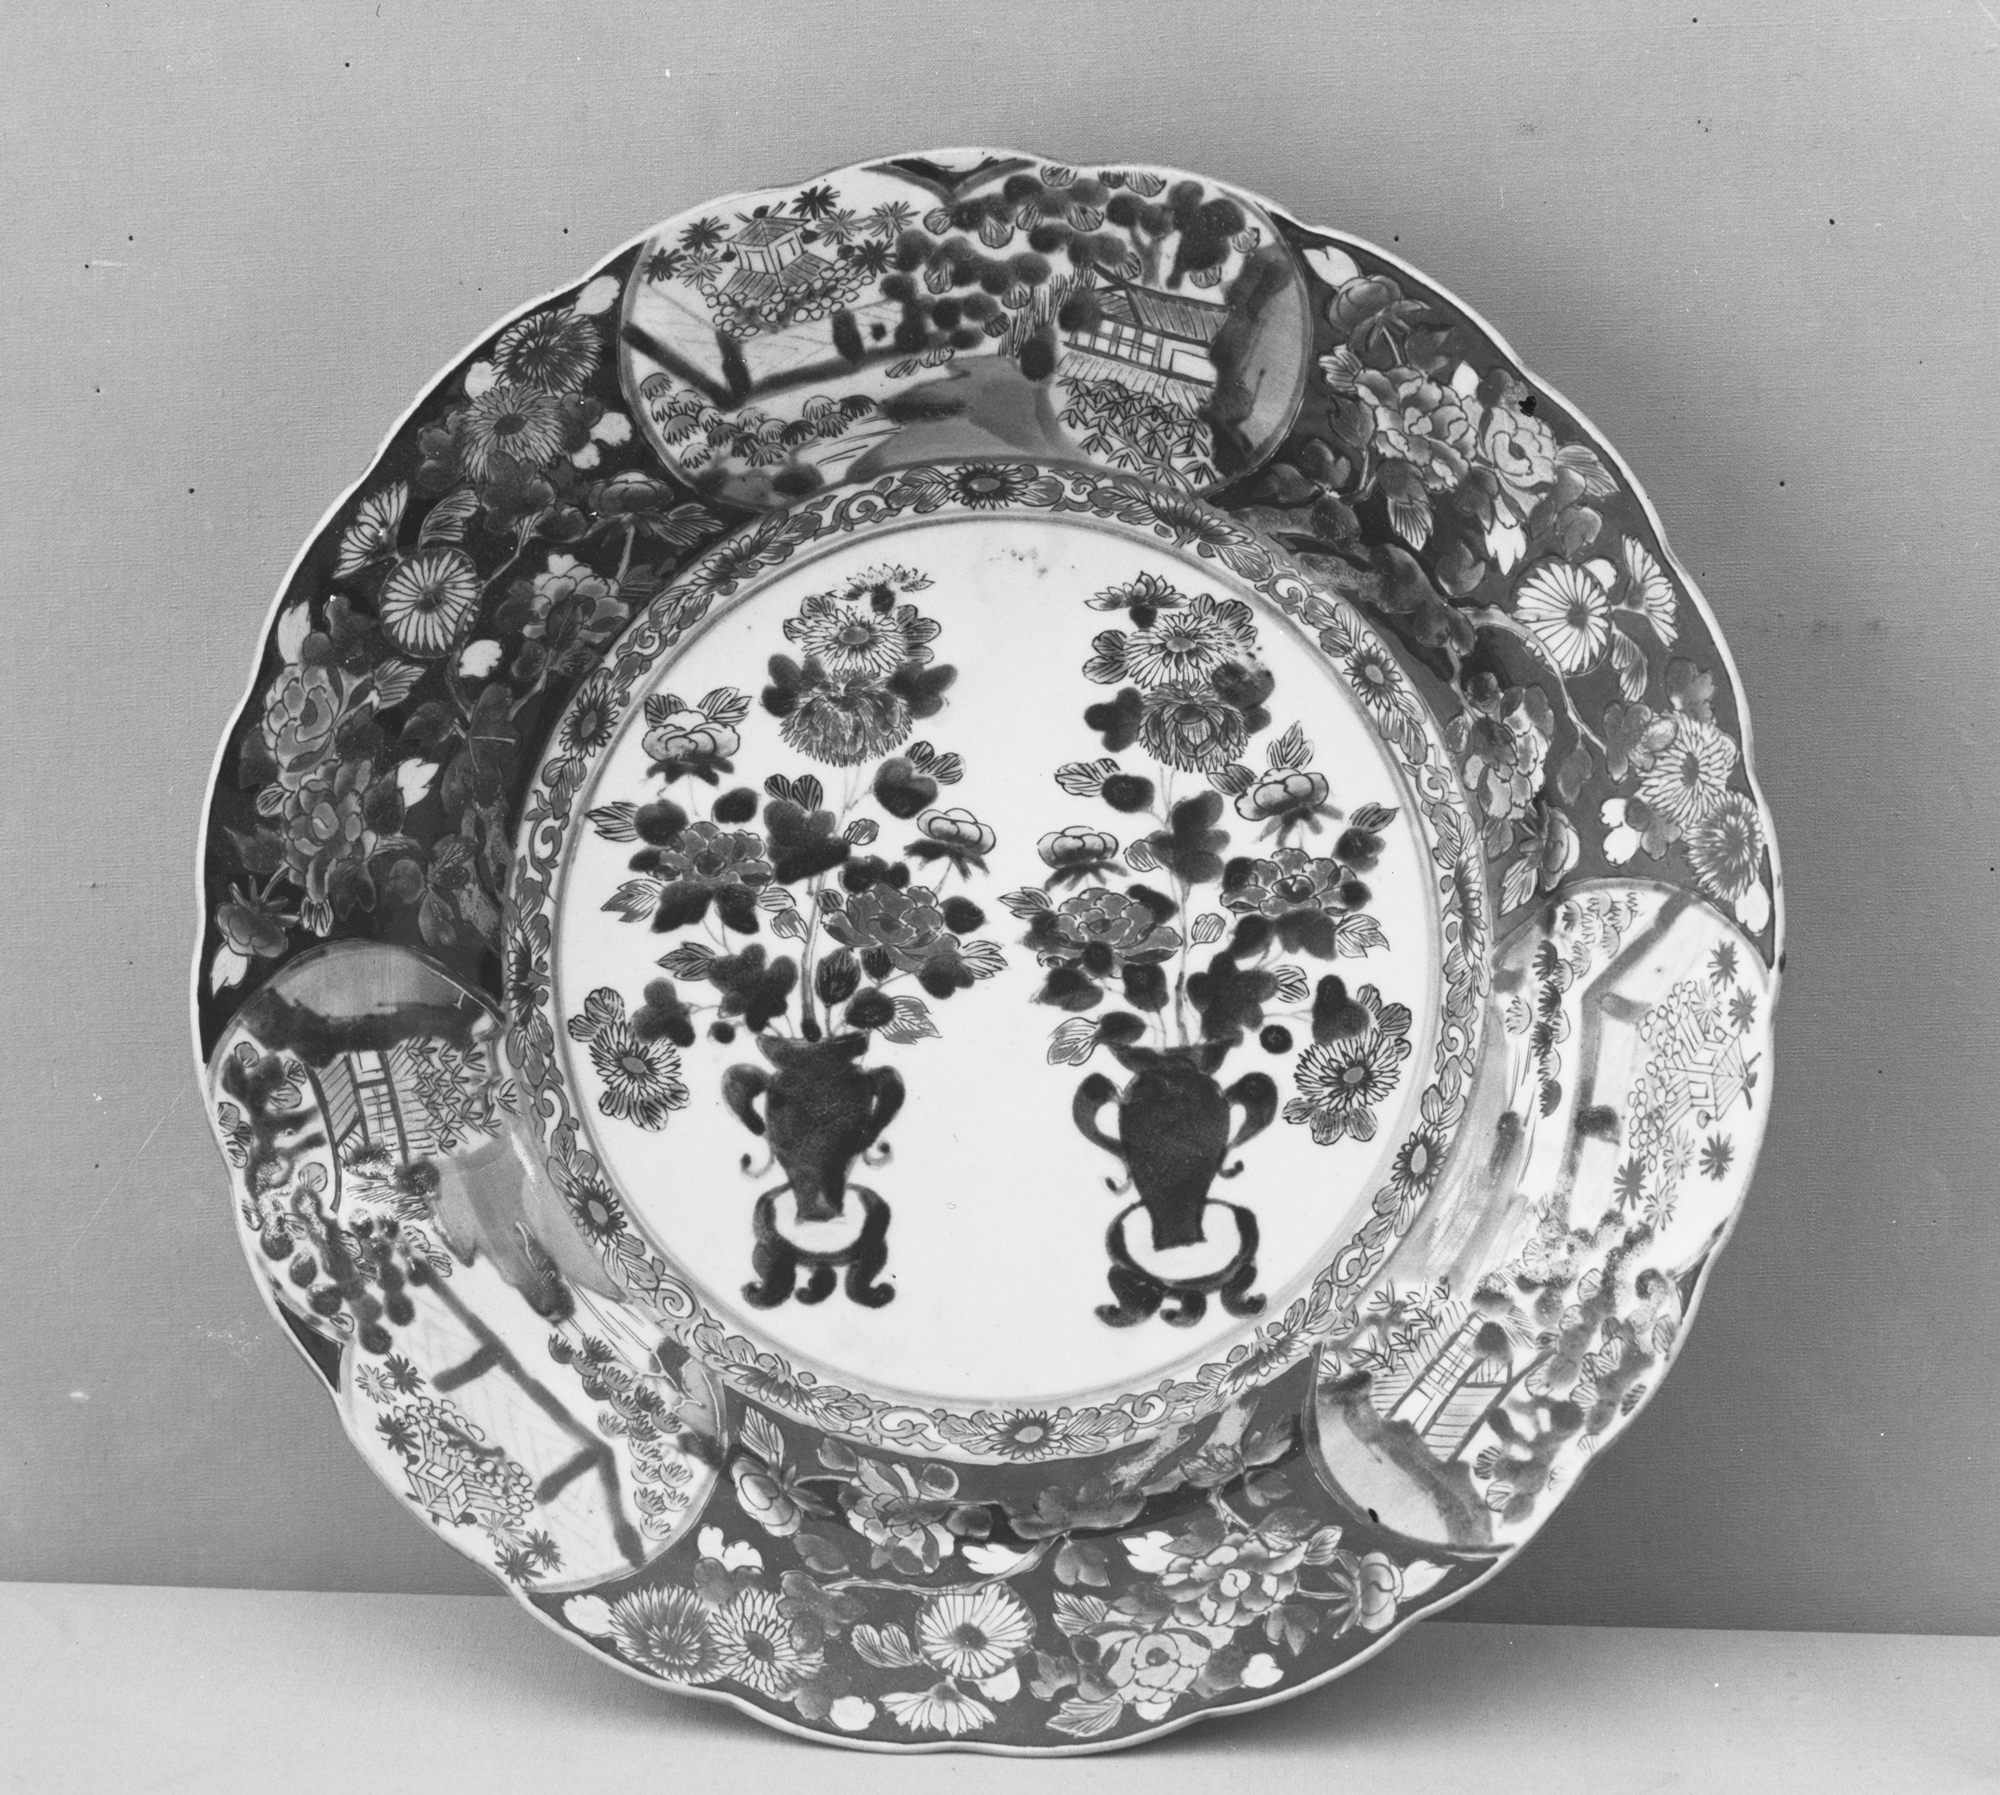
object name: dish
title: Large Dish with Flower Vases and Landscapes in Cartouches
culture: japanese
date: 1667-1733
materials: enamel, gold, porcelain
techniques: overglaze, polychrome, underglaze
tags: flowers,landscapes